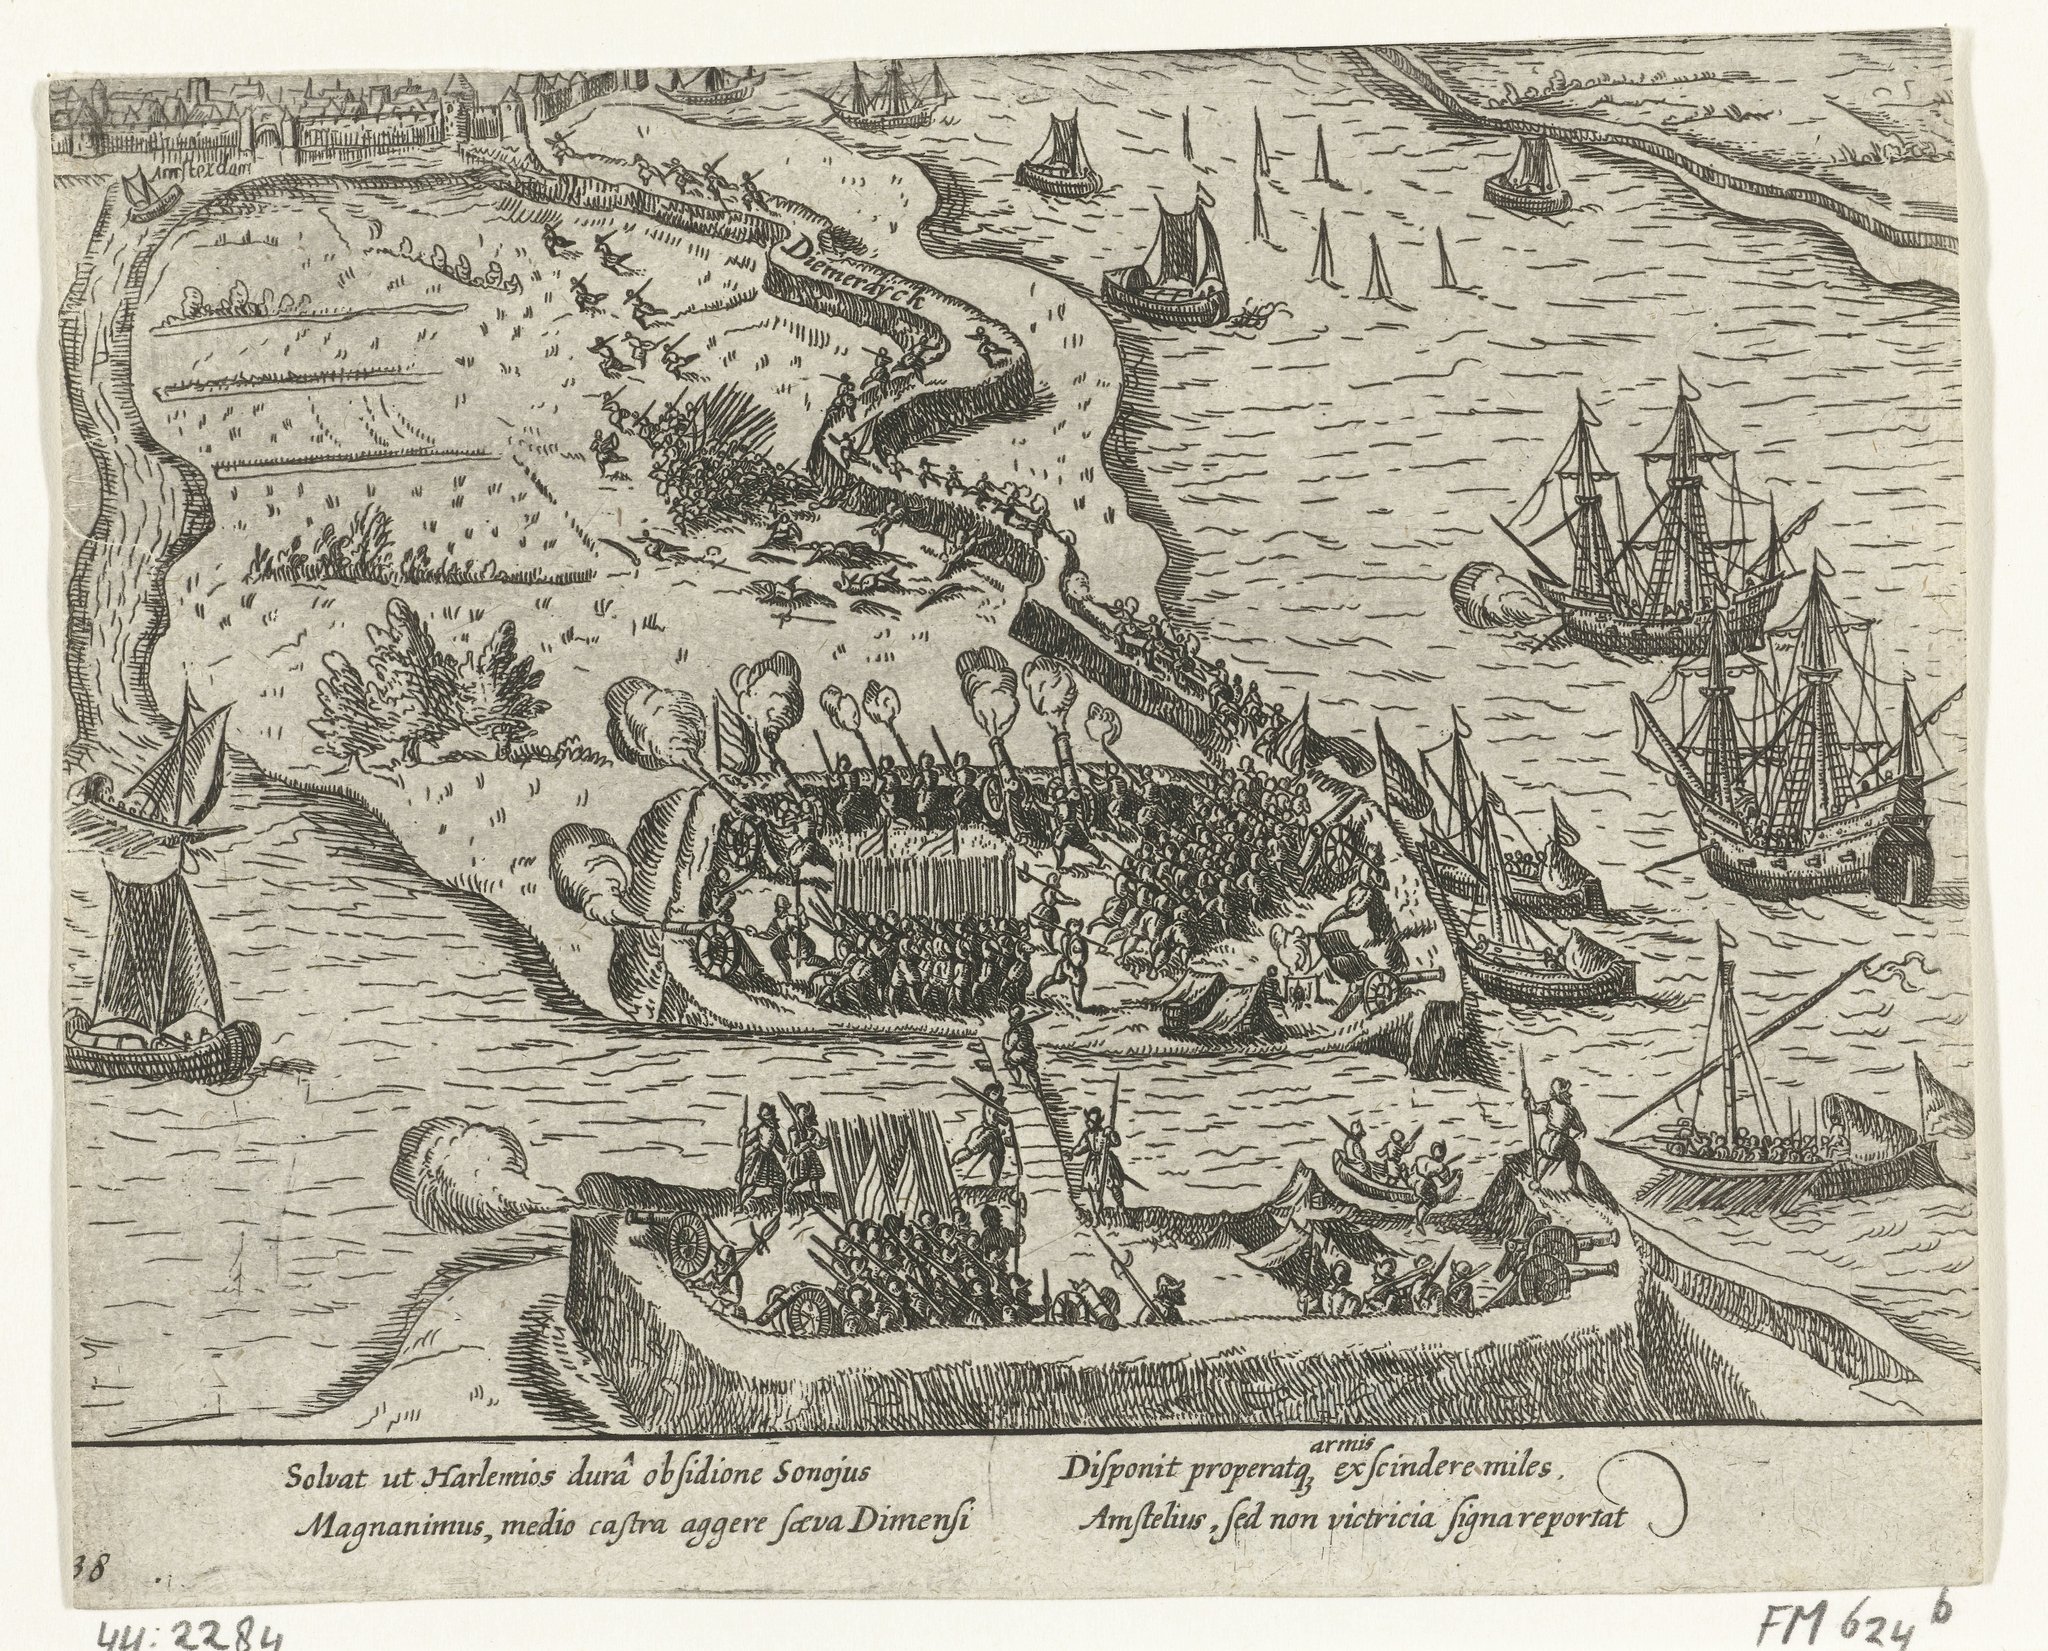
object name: print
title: Slag op de Diemerdijk, 1573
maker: Anonymous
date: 1613-1615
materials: paper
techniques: etching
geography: northern netherlands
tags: kalkar, battle (+ land forces), amsterdam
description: Slag op de Diemerdijk bij Amsterdam, juni 1573. De Diemerdijk door soldaten onder Sonoy op 2 juni veroverd, doorgegraven, versterkt en bezet gehouden tot 17 juli. Met onderschrift van 4 regels in het Latijn. Genummerd: 38. De achterzijde onbedrukt.